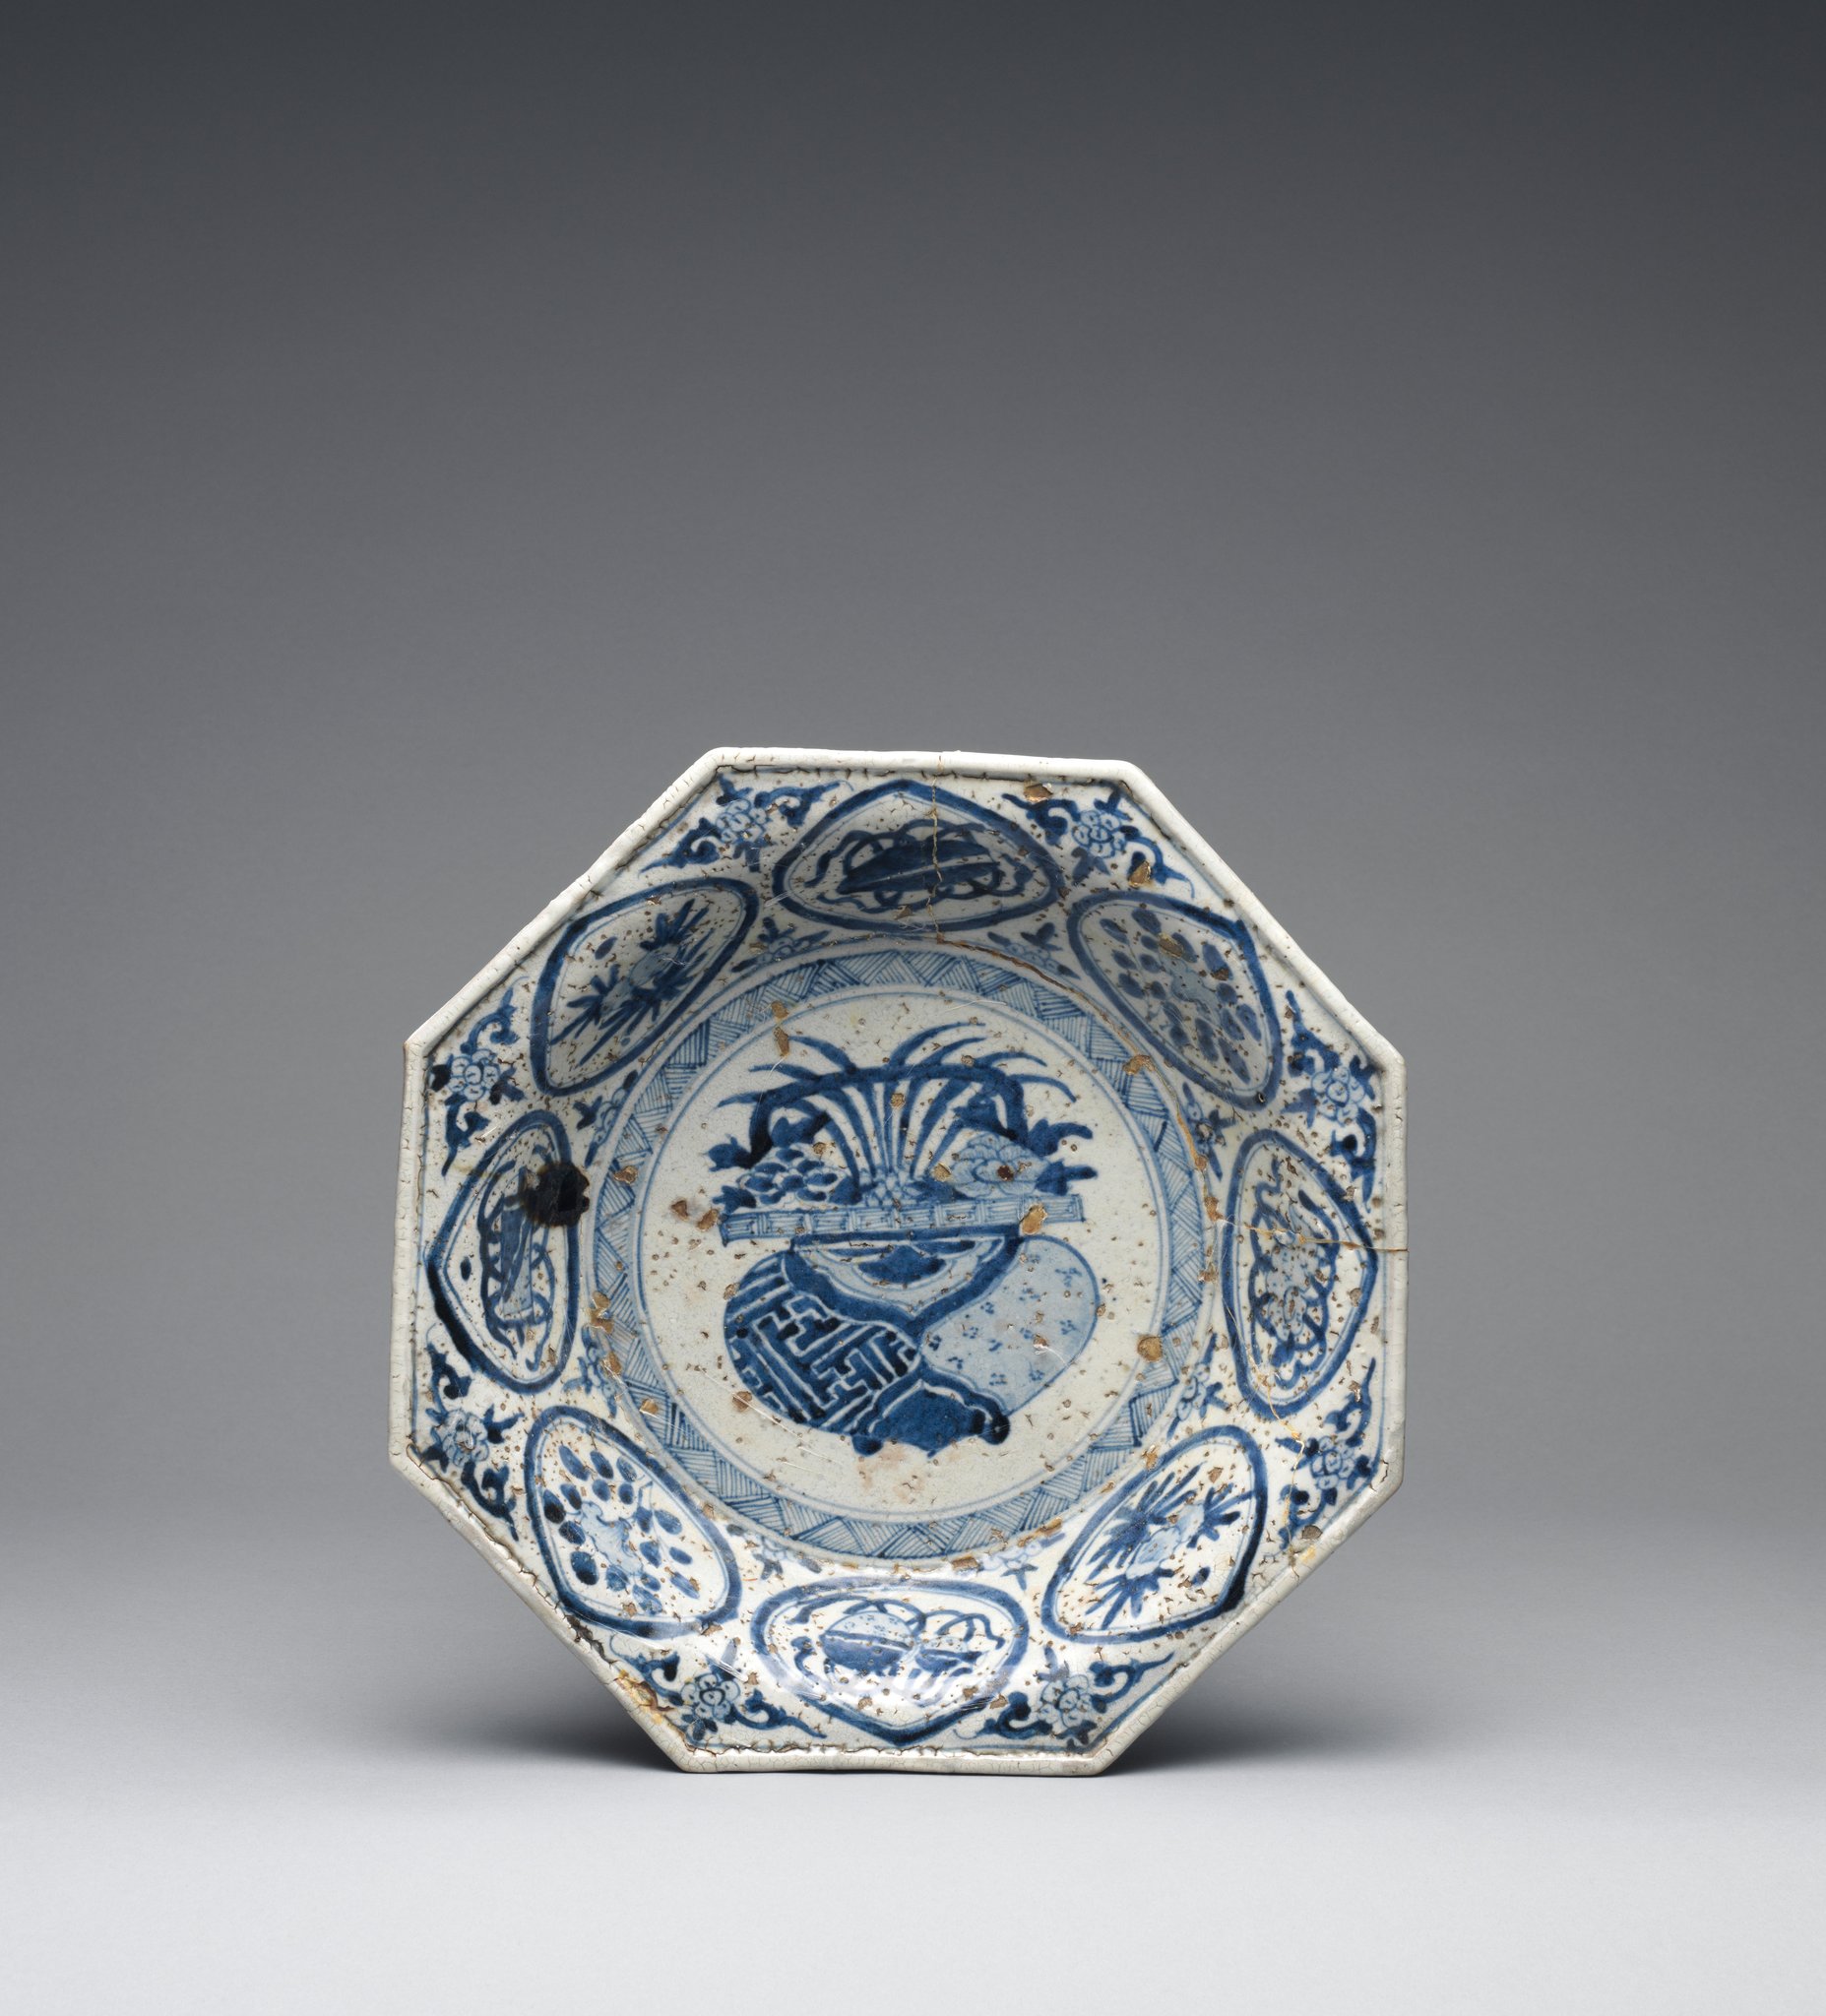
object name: dish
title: Octagonal dish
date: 1601-1700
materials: stoneware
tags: flowers